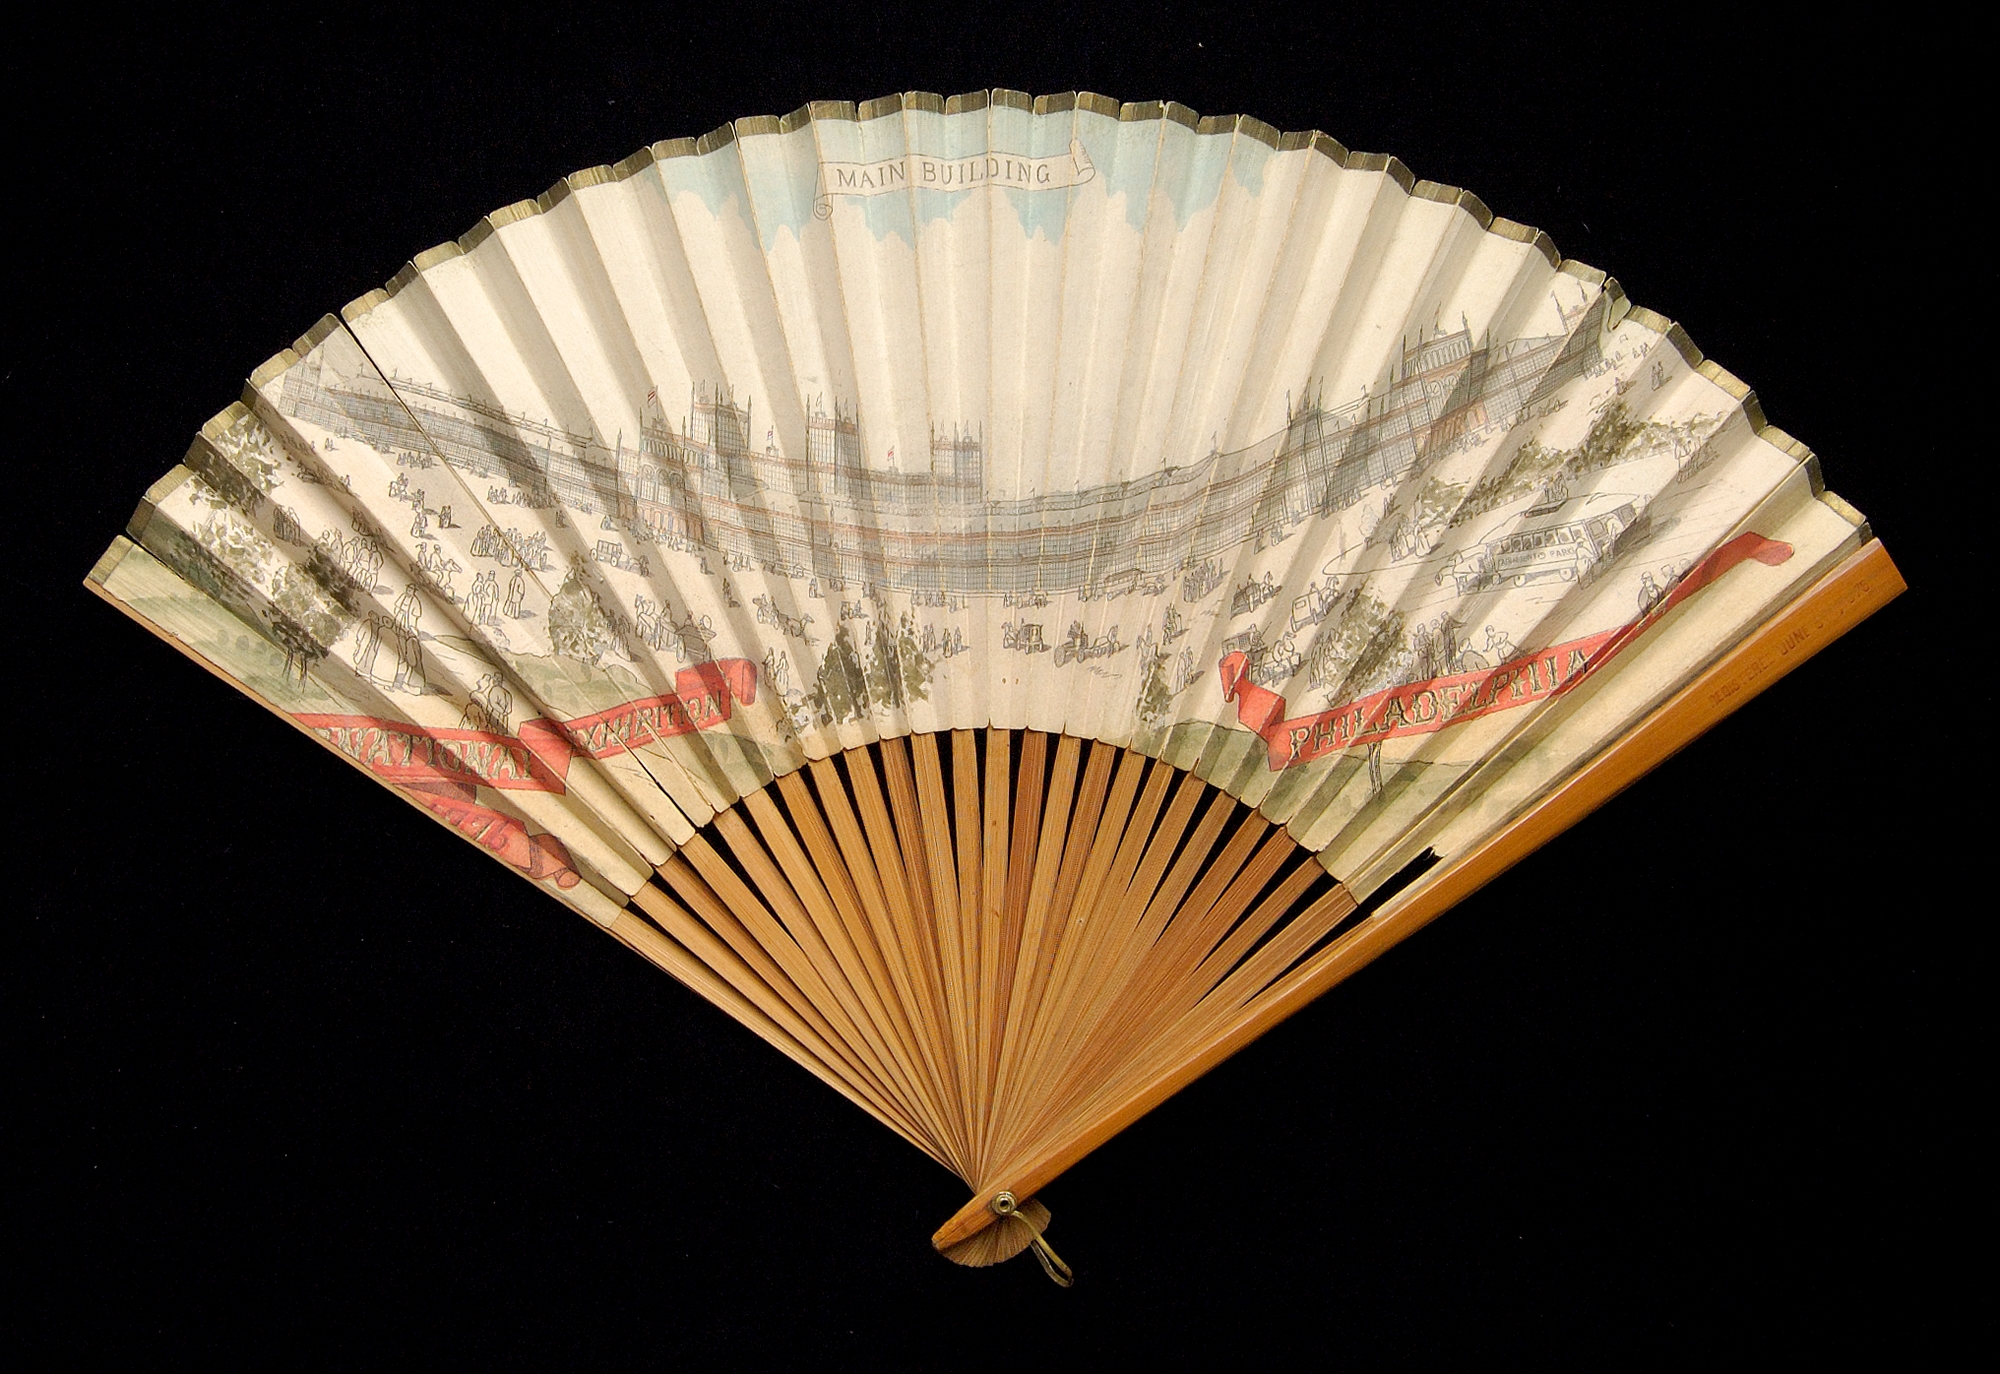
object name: fan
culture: american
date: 1875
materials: metal, paper, wood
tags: buildings